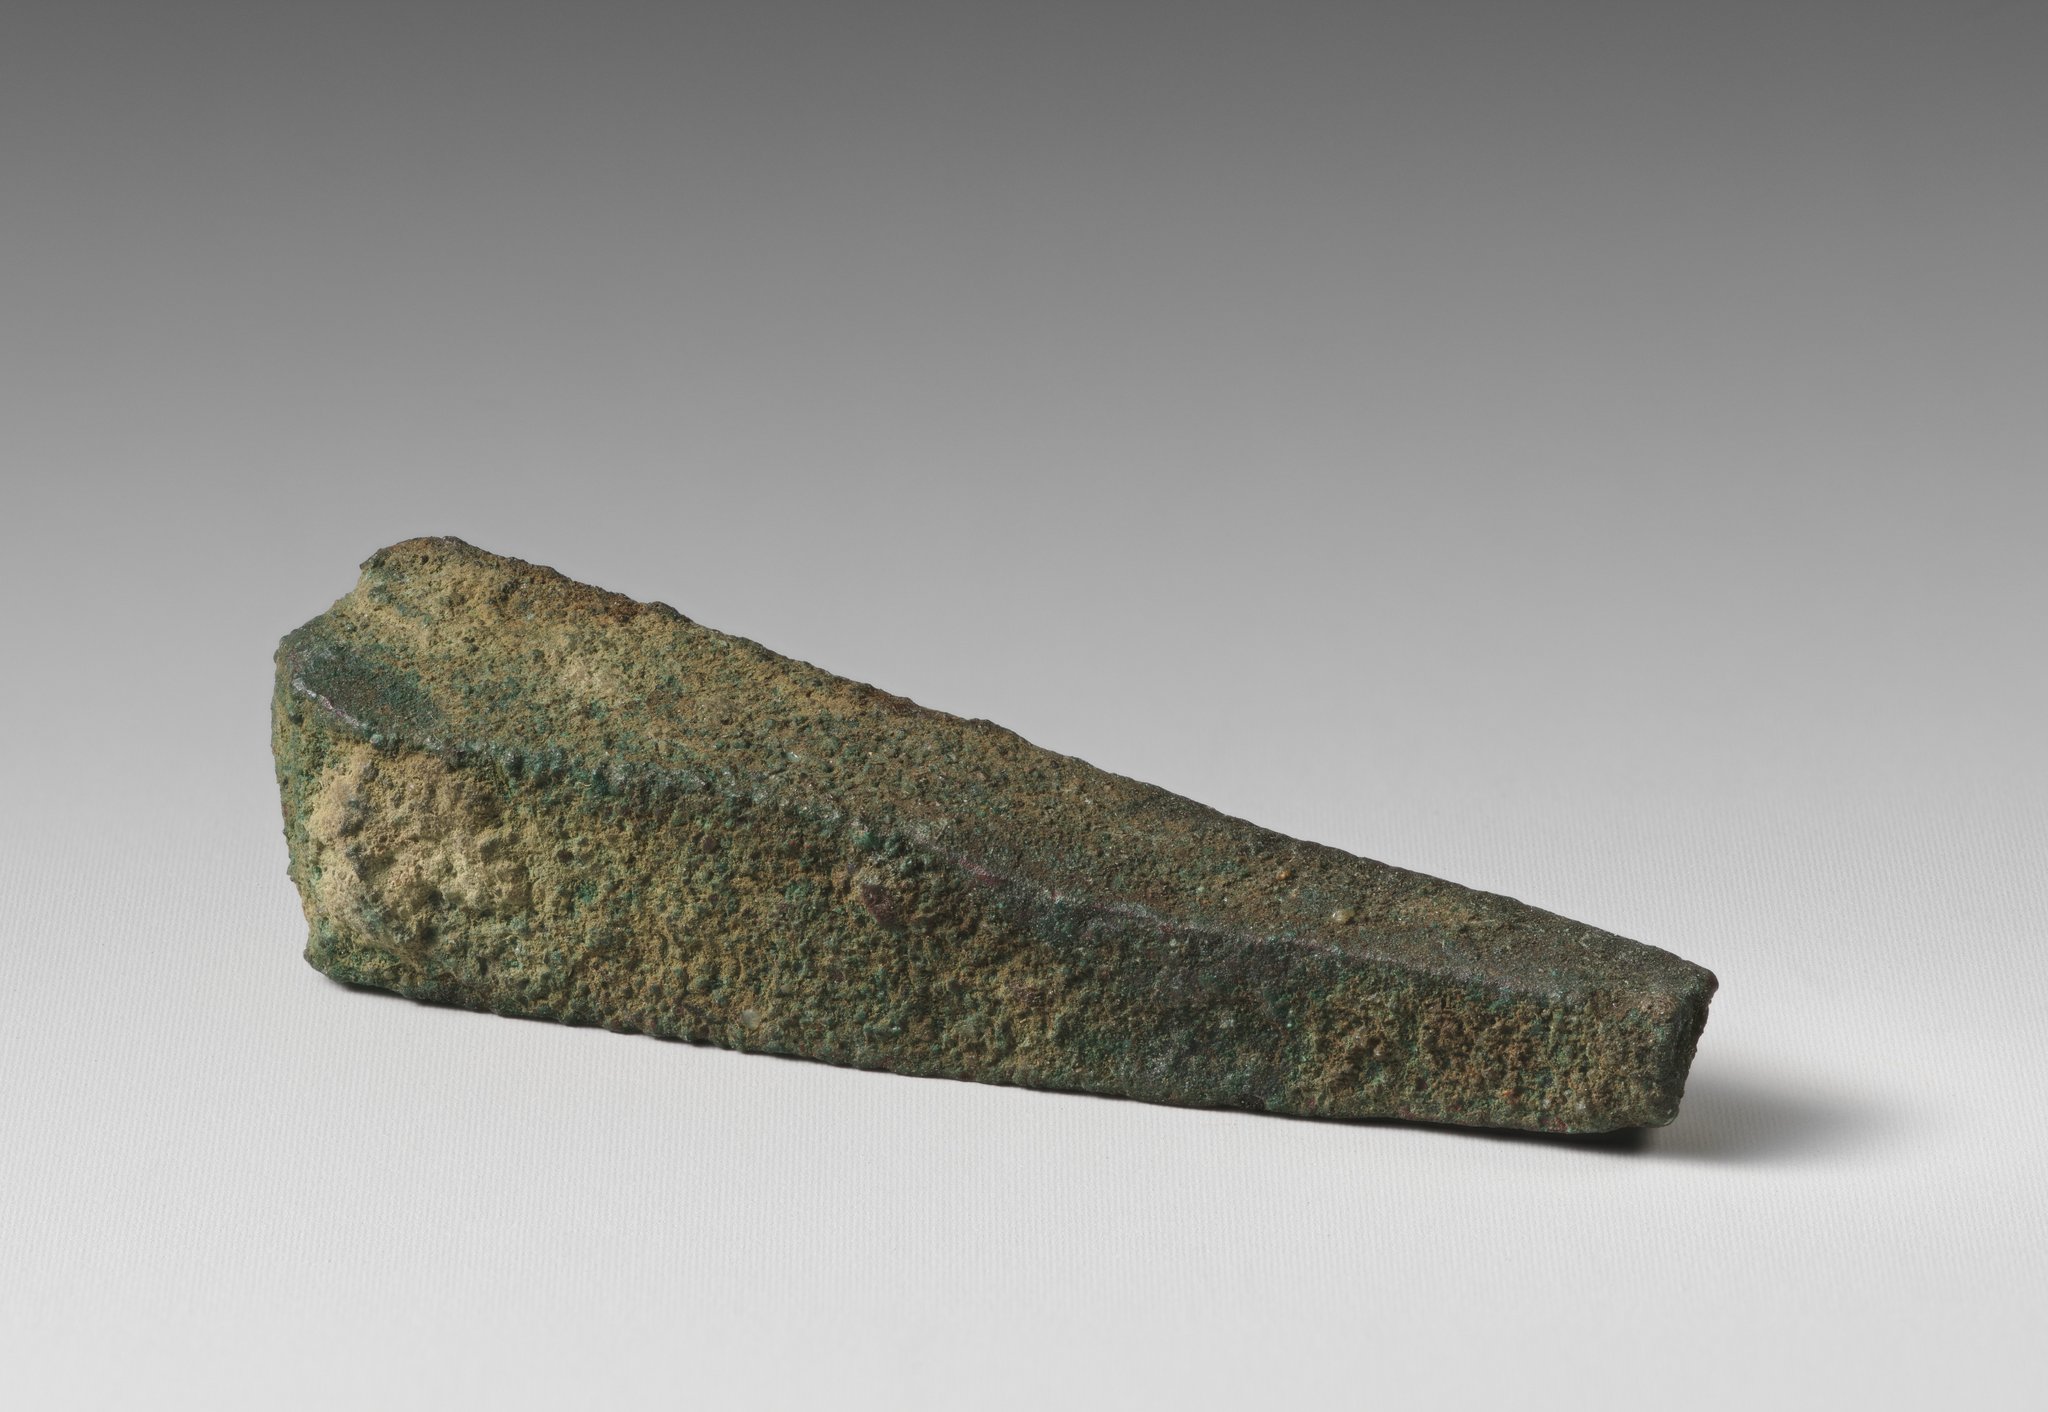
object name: nail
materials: bronze, copper alloy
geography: egypt